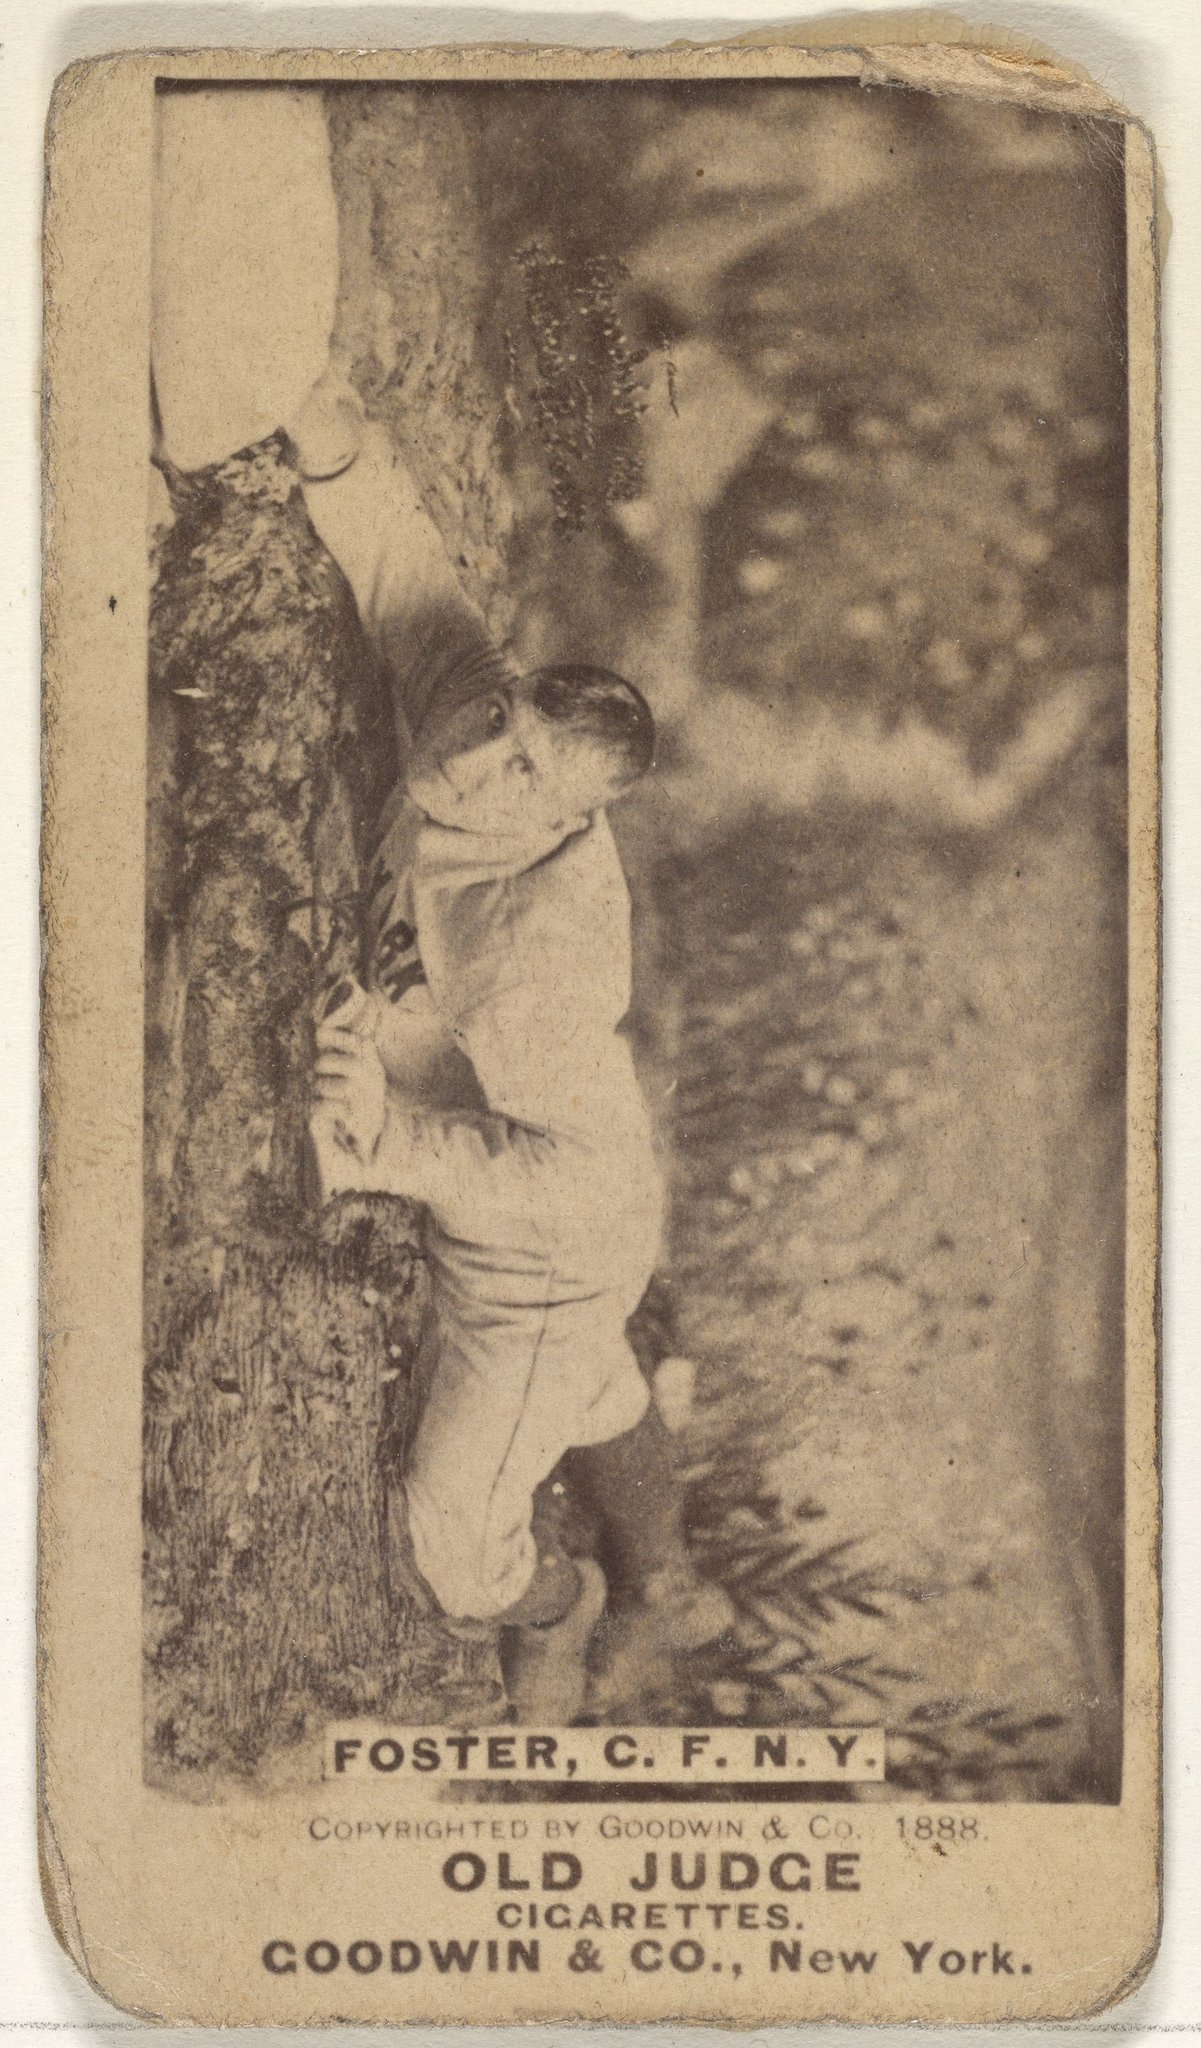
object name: baseball card, photograph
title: Elmer Ellsworth Foster, Center Field, New York, from the Old Judge series (N172) for Old Judge Cigarettes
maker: goodwin & company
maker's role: publisher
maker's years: 1850-1950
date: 1888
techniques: albumen silver print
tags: men,portraits,baseball,athletes